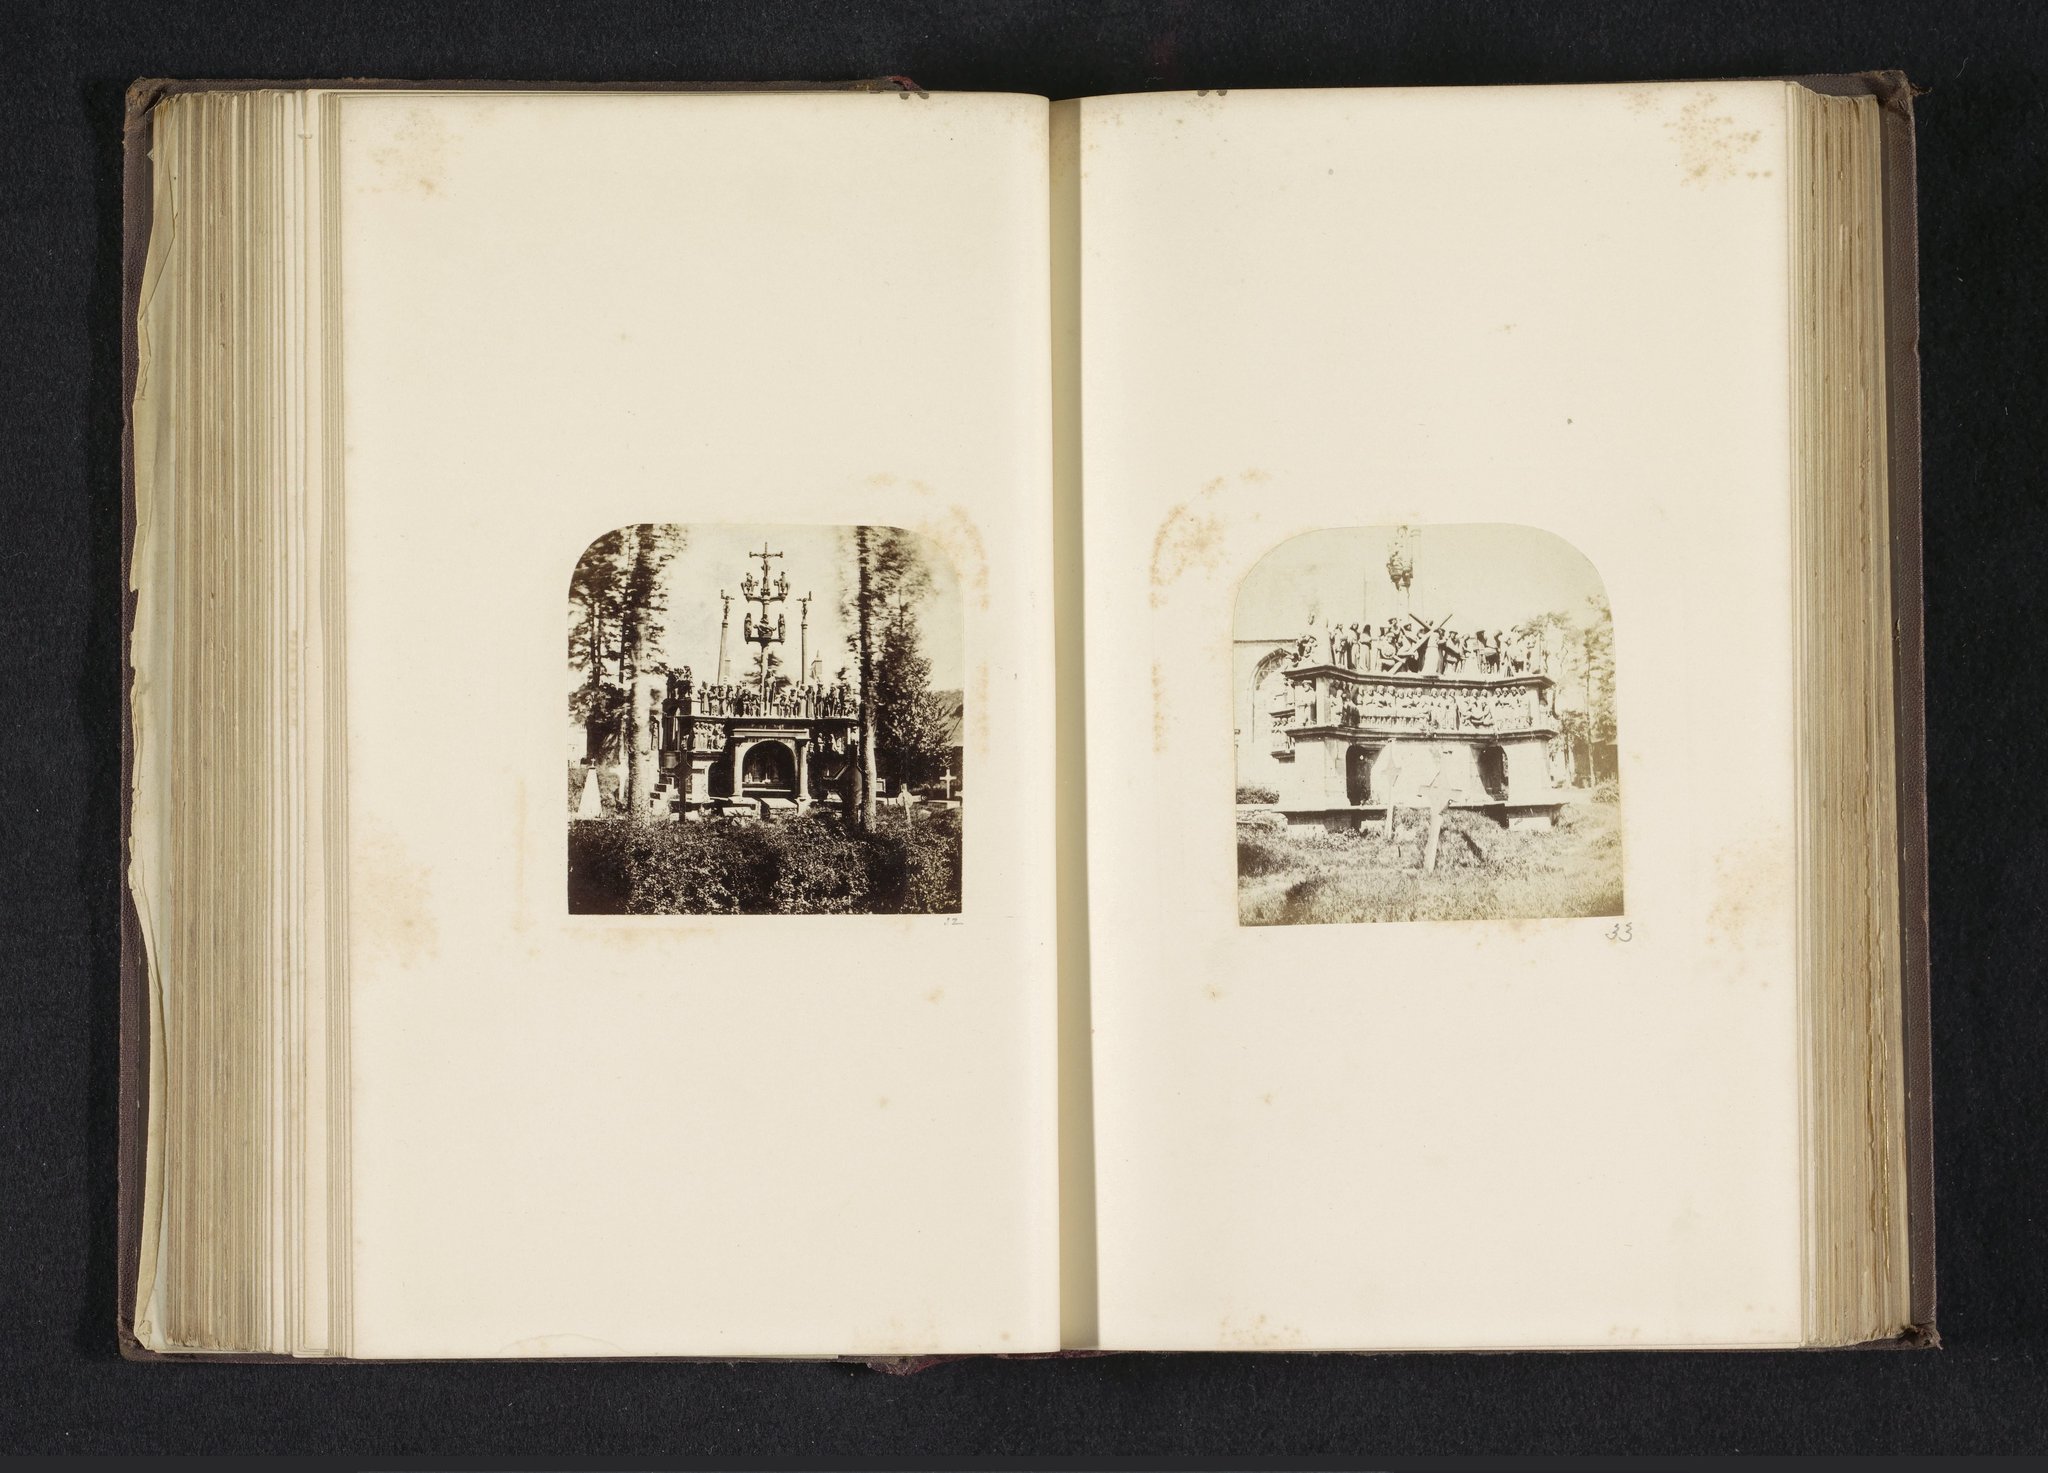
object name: page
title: Beeldhouwwerken op het kerkhof van Plougastel, gezien vanuit het zuiden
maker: taylor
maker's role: fotograaf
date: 1850-1859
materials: photographic support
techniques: albumen print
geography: plougastel-daoulas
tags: piece of sculpture, reproduction of a piece of sculpture, churchyard, cemetery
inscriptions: number: ‘33’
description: Foto op tweede ongenummerde pagina na pagina 136.